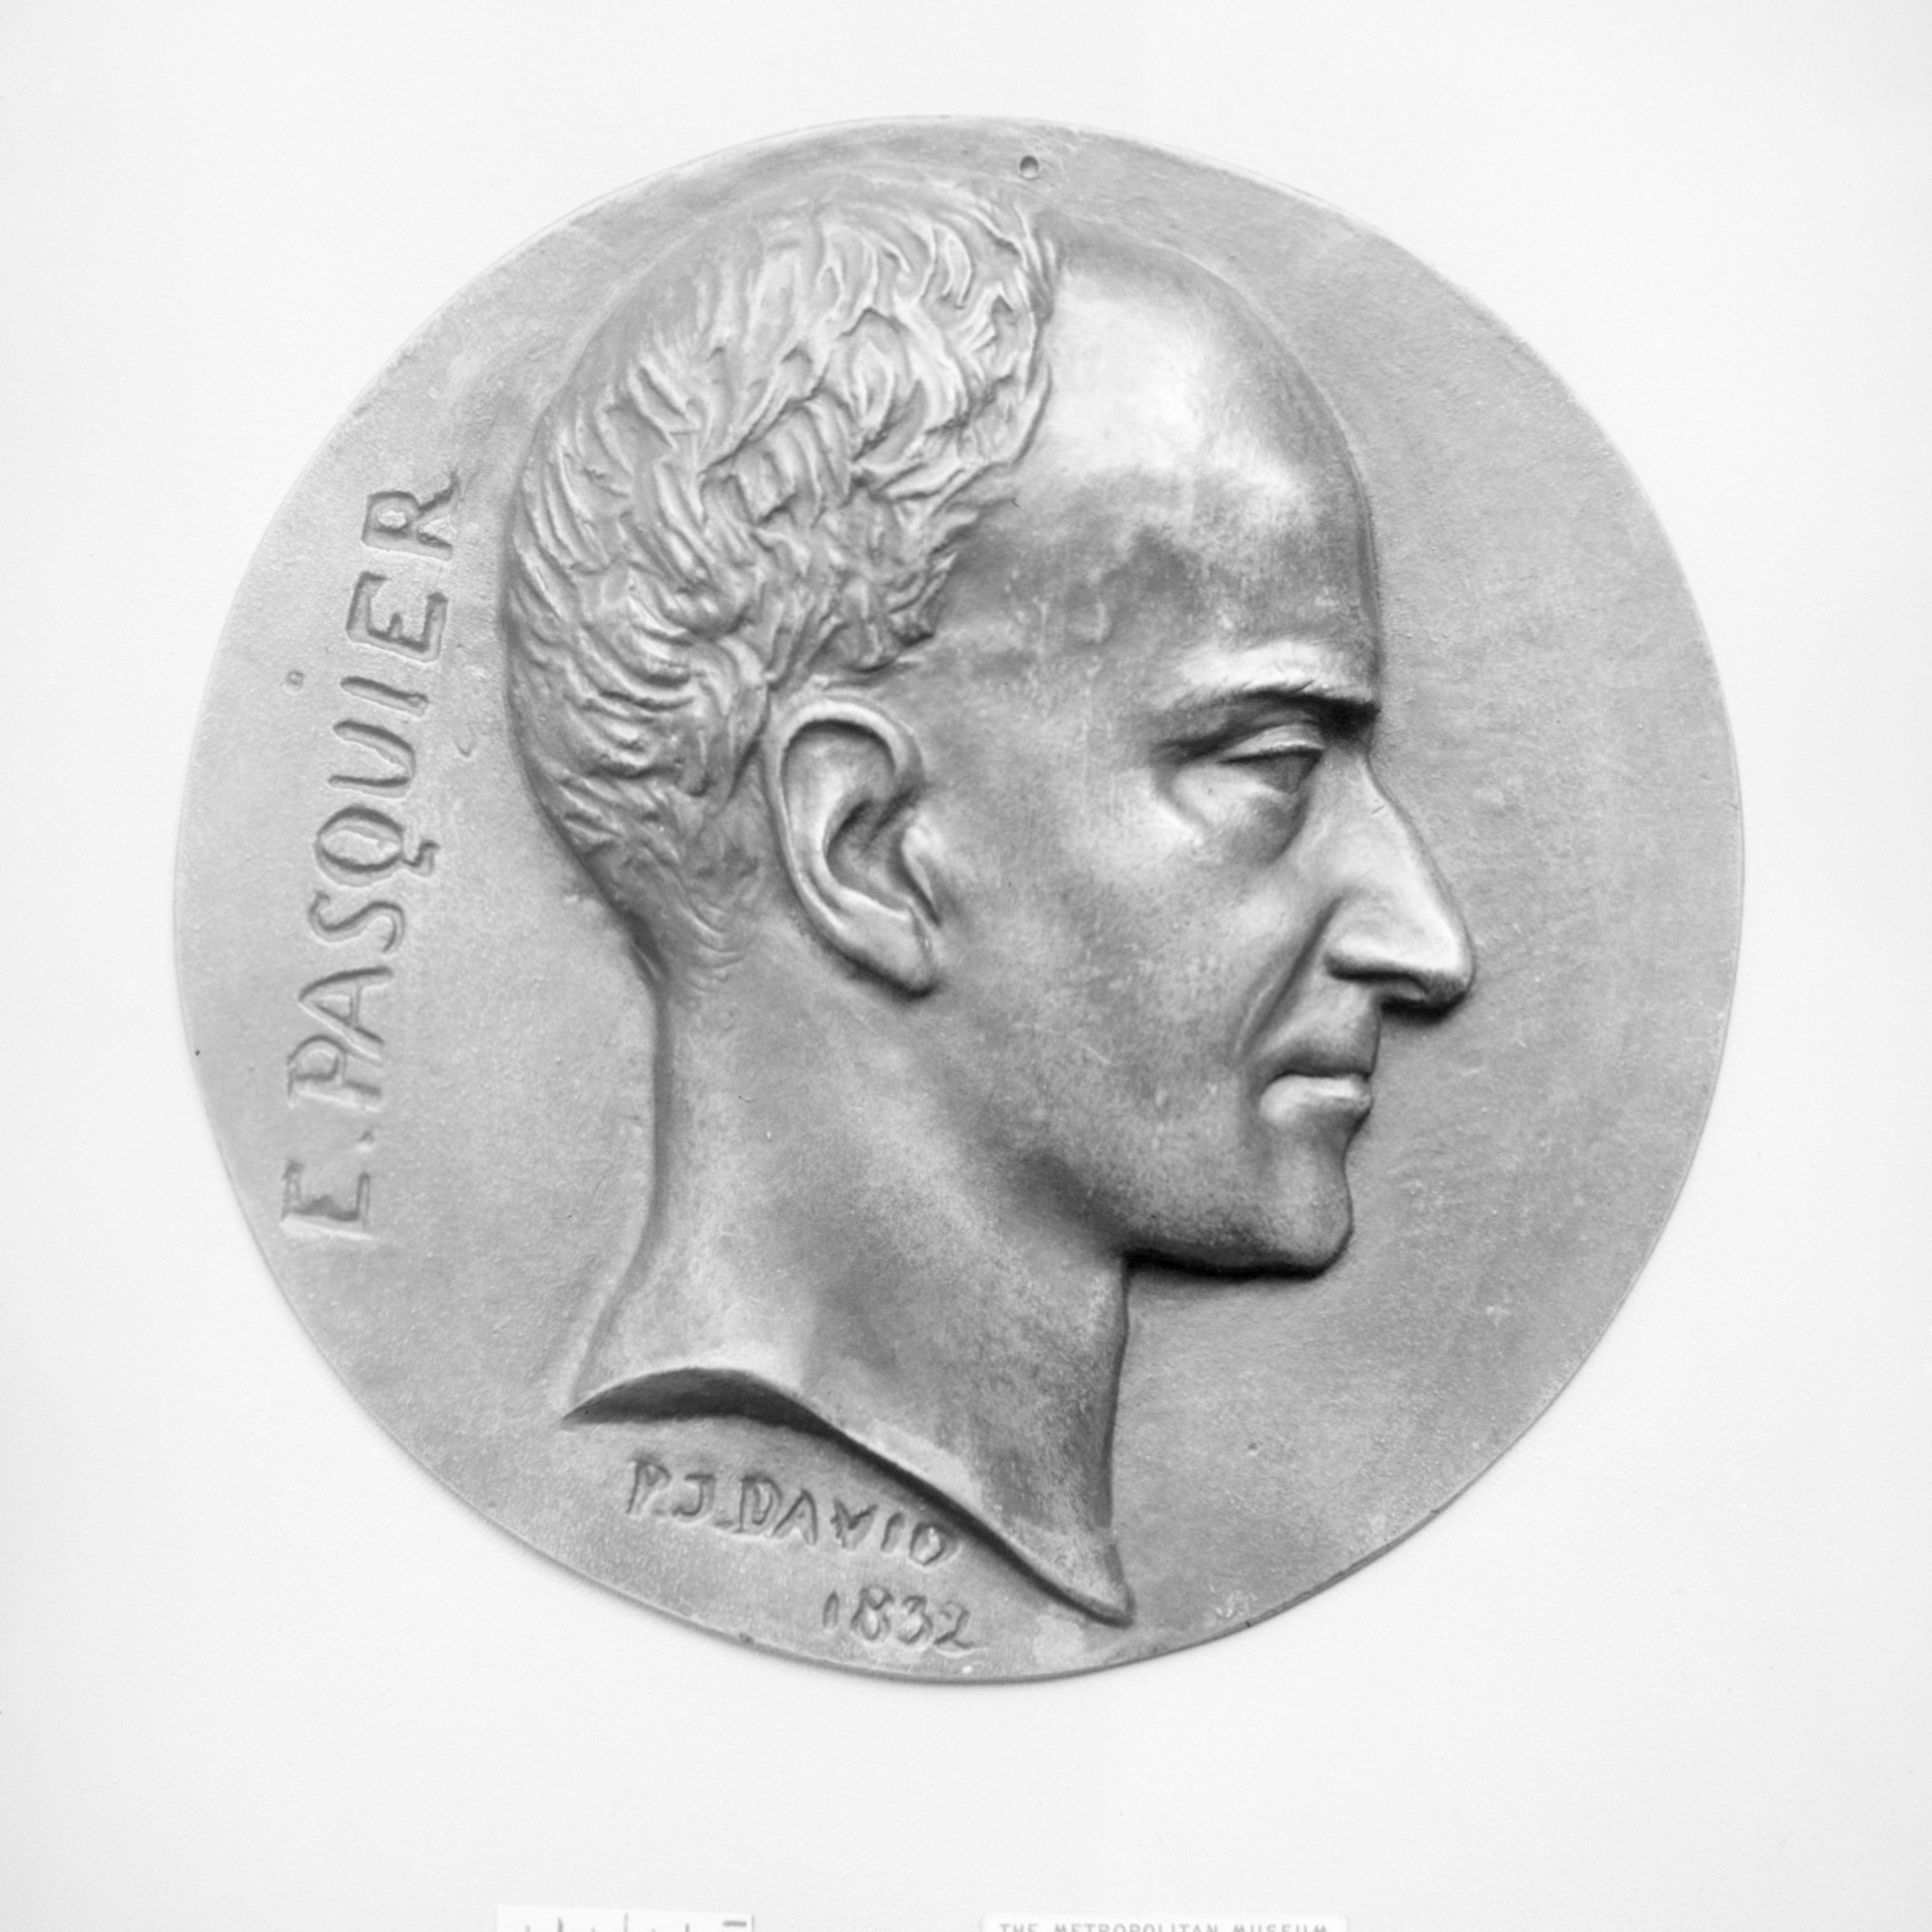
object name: medallion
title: Etienne Denis Duc de Pasquier (1767–1862), French statesman and President of the House of Peers, 1844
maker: pierre jean david d'angers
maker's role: artist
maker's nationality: french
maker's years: 1788-1856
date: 1832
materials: bronze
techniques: casting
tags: men,profiles